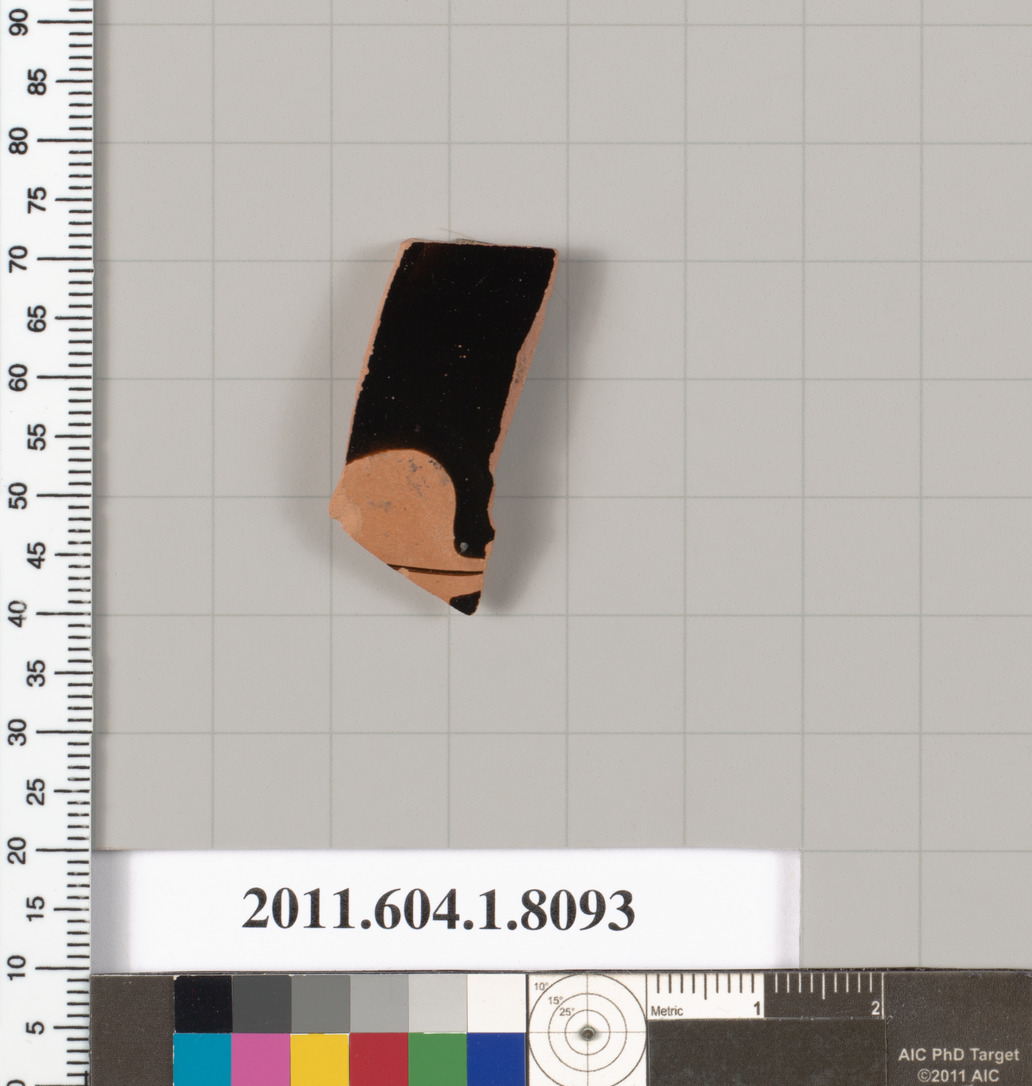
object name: kylix fragment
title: Terracotta fragment of a kylix (drinking cup)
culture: greek, attic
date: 510-500 BCE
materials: terracotta